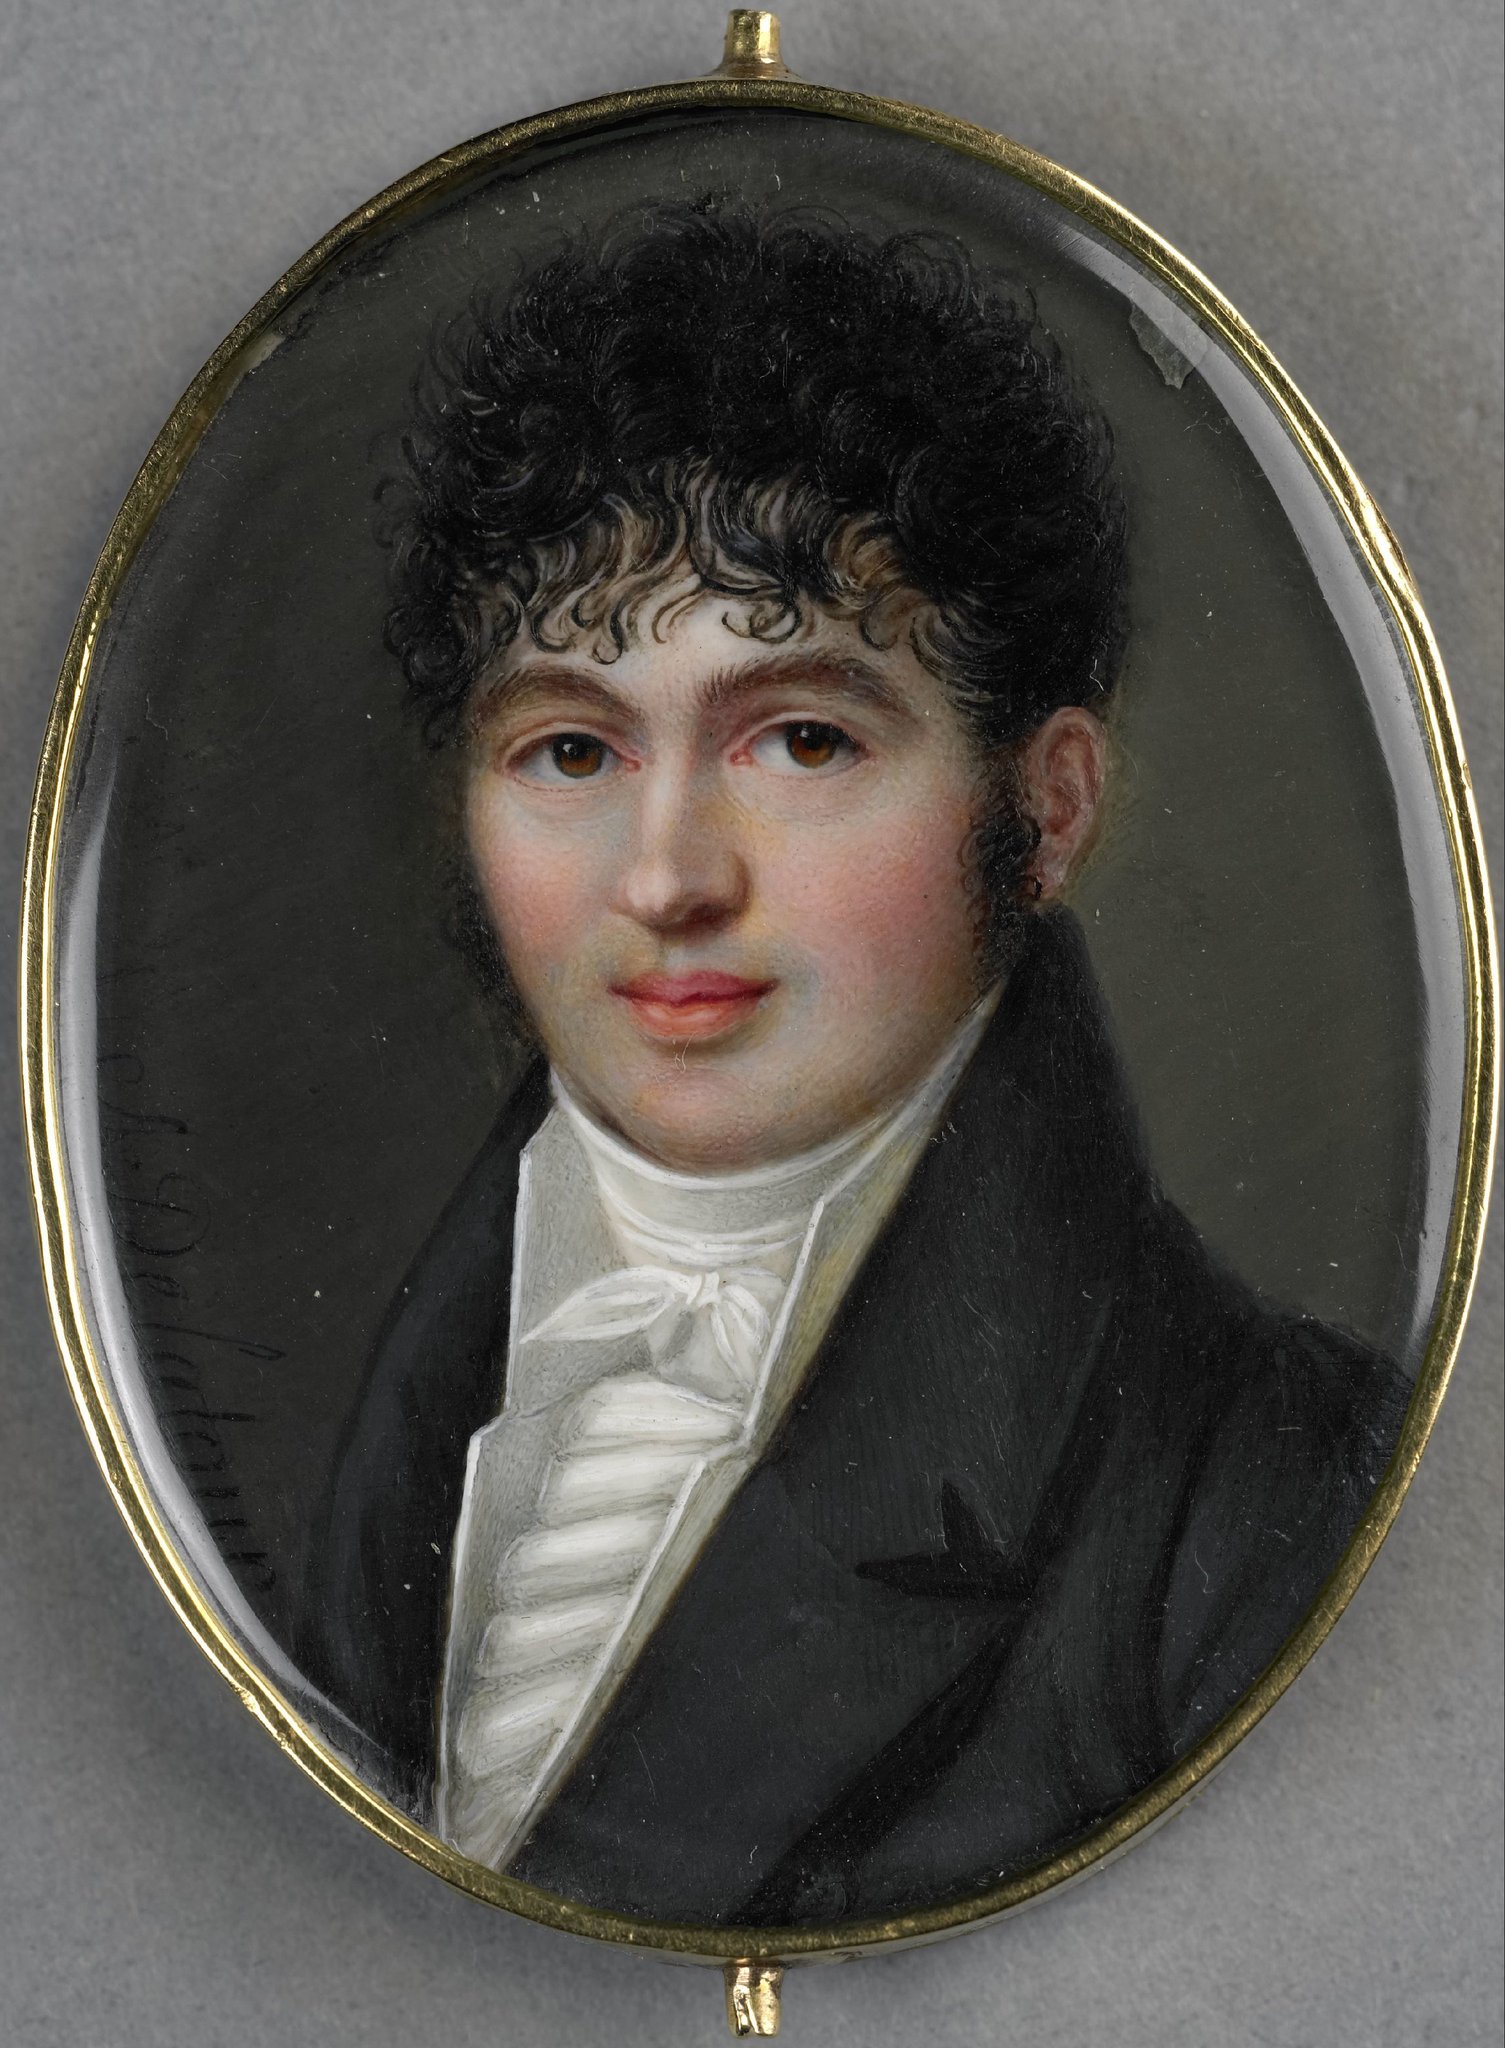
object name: painting, miniature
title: Portret van een onbekende man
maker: alexandre de latour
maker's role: miniatuurschilder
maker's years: 1780-1858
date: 1810-1820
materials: glass, hair, ivory, metal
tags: historical persons not known by name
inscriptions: signature: ‘A. De la tour’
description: Alexandre Delatour (1780 - 1858). Portrait of an unknown man. Ivory,..., c. 1815